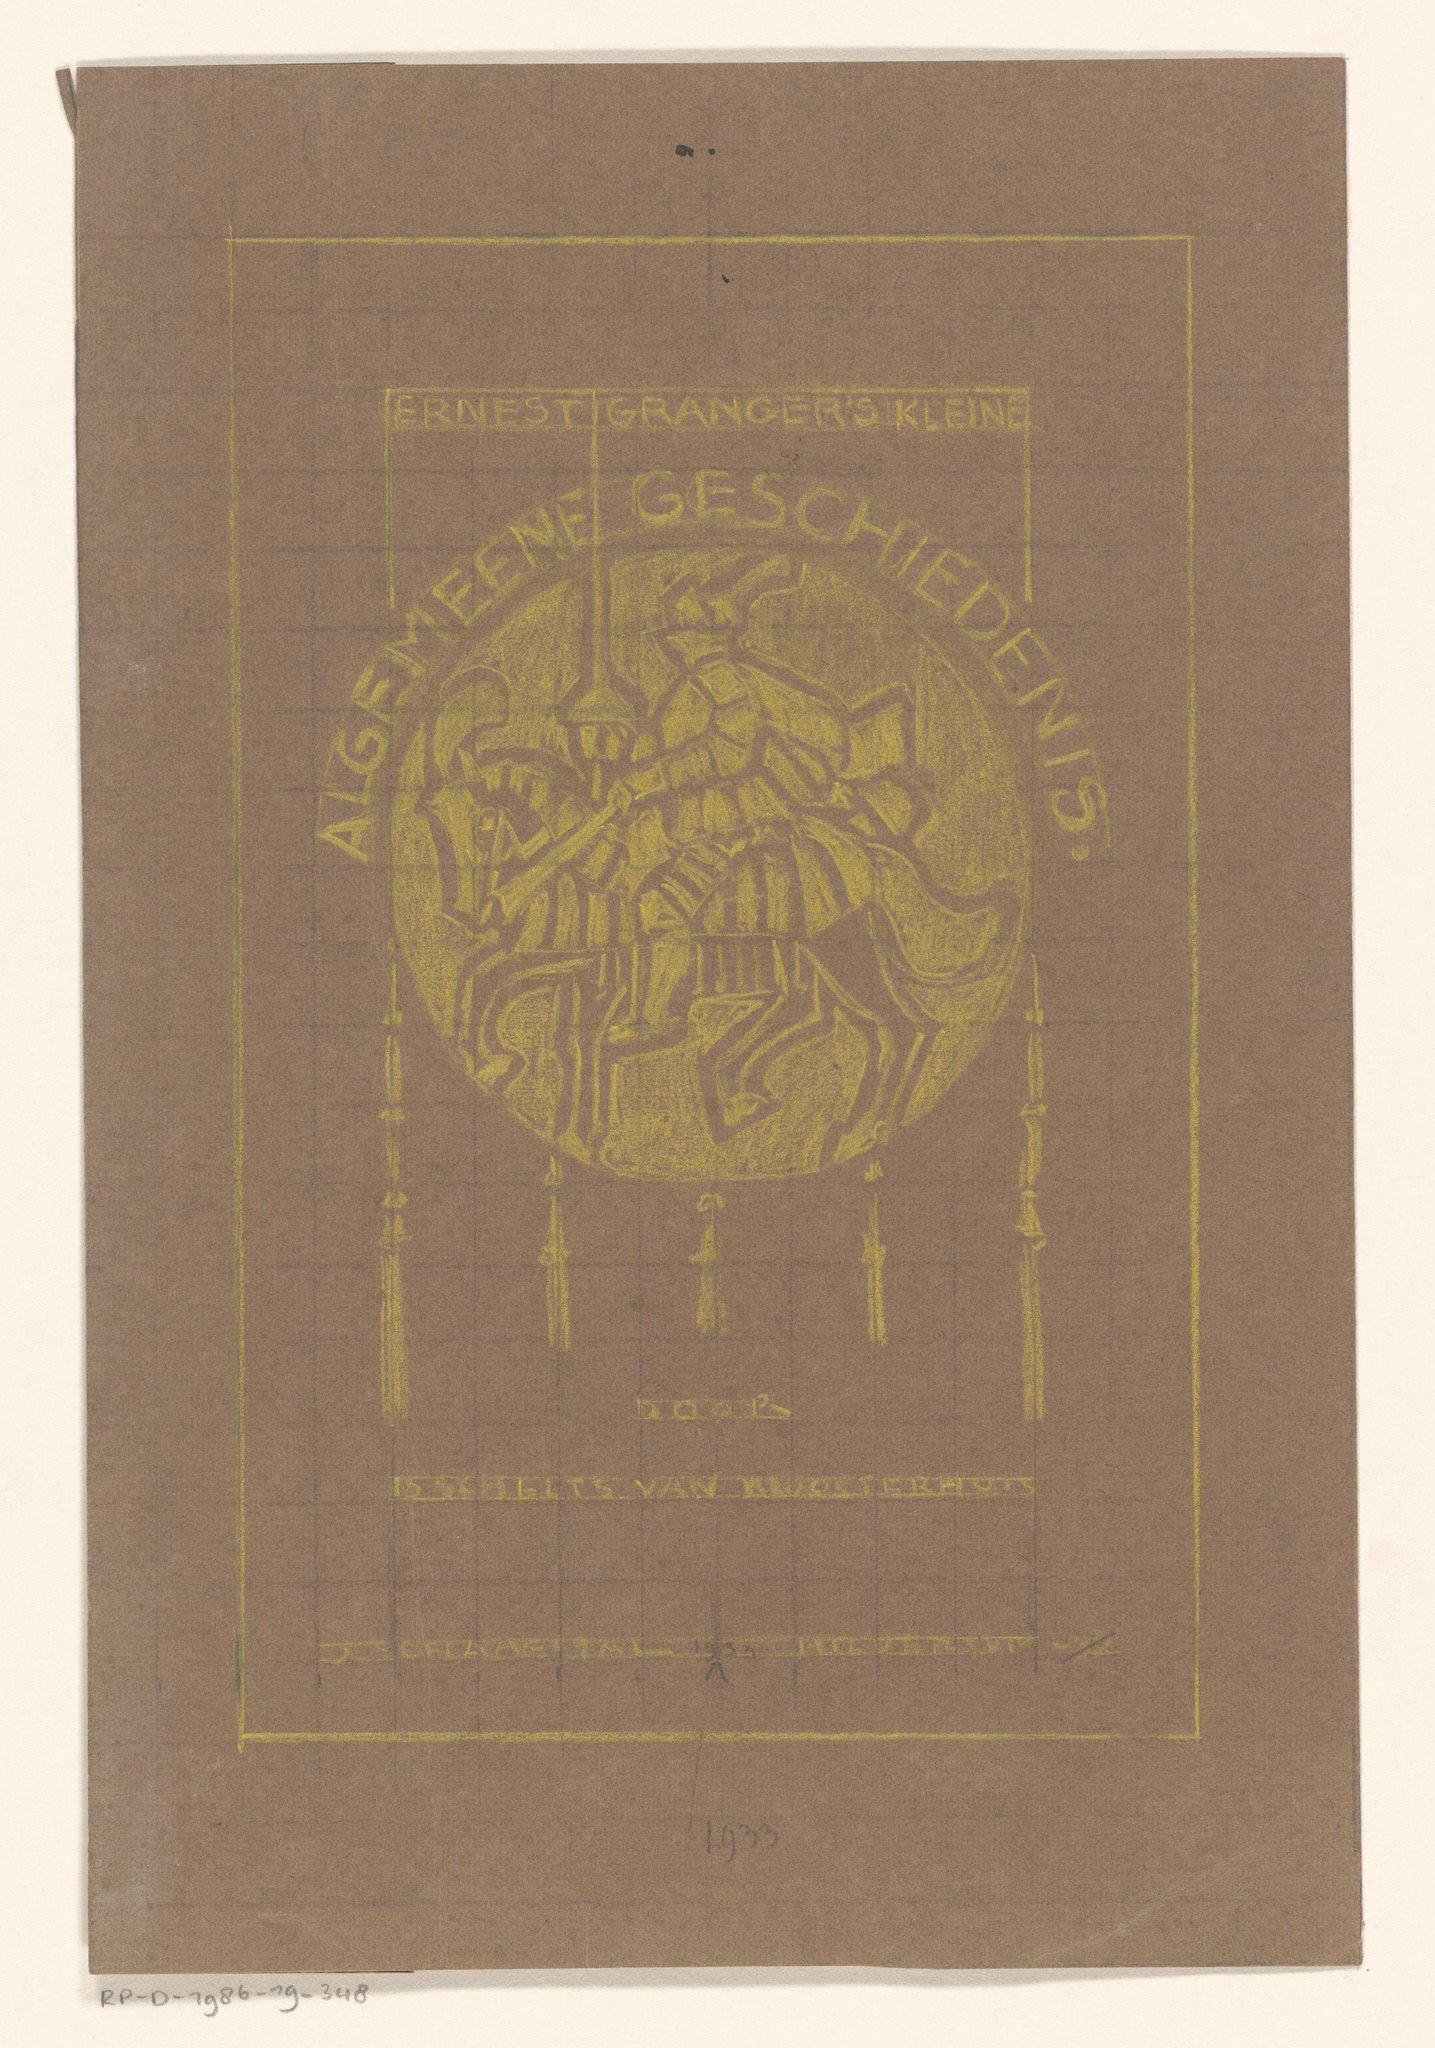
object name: study for binding design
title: Bandontwerp voor: Ernest Granger's kleine algemeene geschiedenis, 1933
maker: reinier willem petrus de vries (1874-1953)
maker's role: draughtsman, print maker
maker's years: 1874-1953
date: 1933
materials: chalk, paper, pencil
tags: riding a horse, ass, or mule; rider, horseman, knight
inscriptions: annotation: ‘1933’, collector's mark: ‘R:MVS.’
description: Bandontwerp voor: Schelts van Kloosterhuis, B. (vert.). Ernest Granger's kleine algemeene geschiedenis. 5e druk. Hilversum: Schaafstal, 1933.